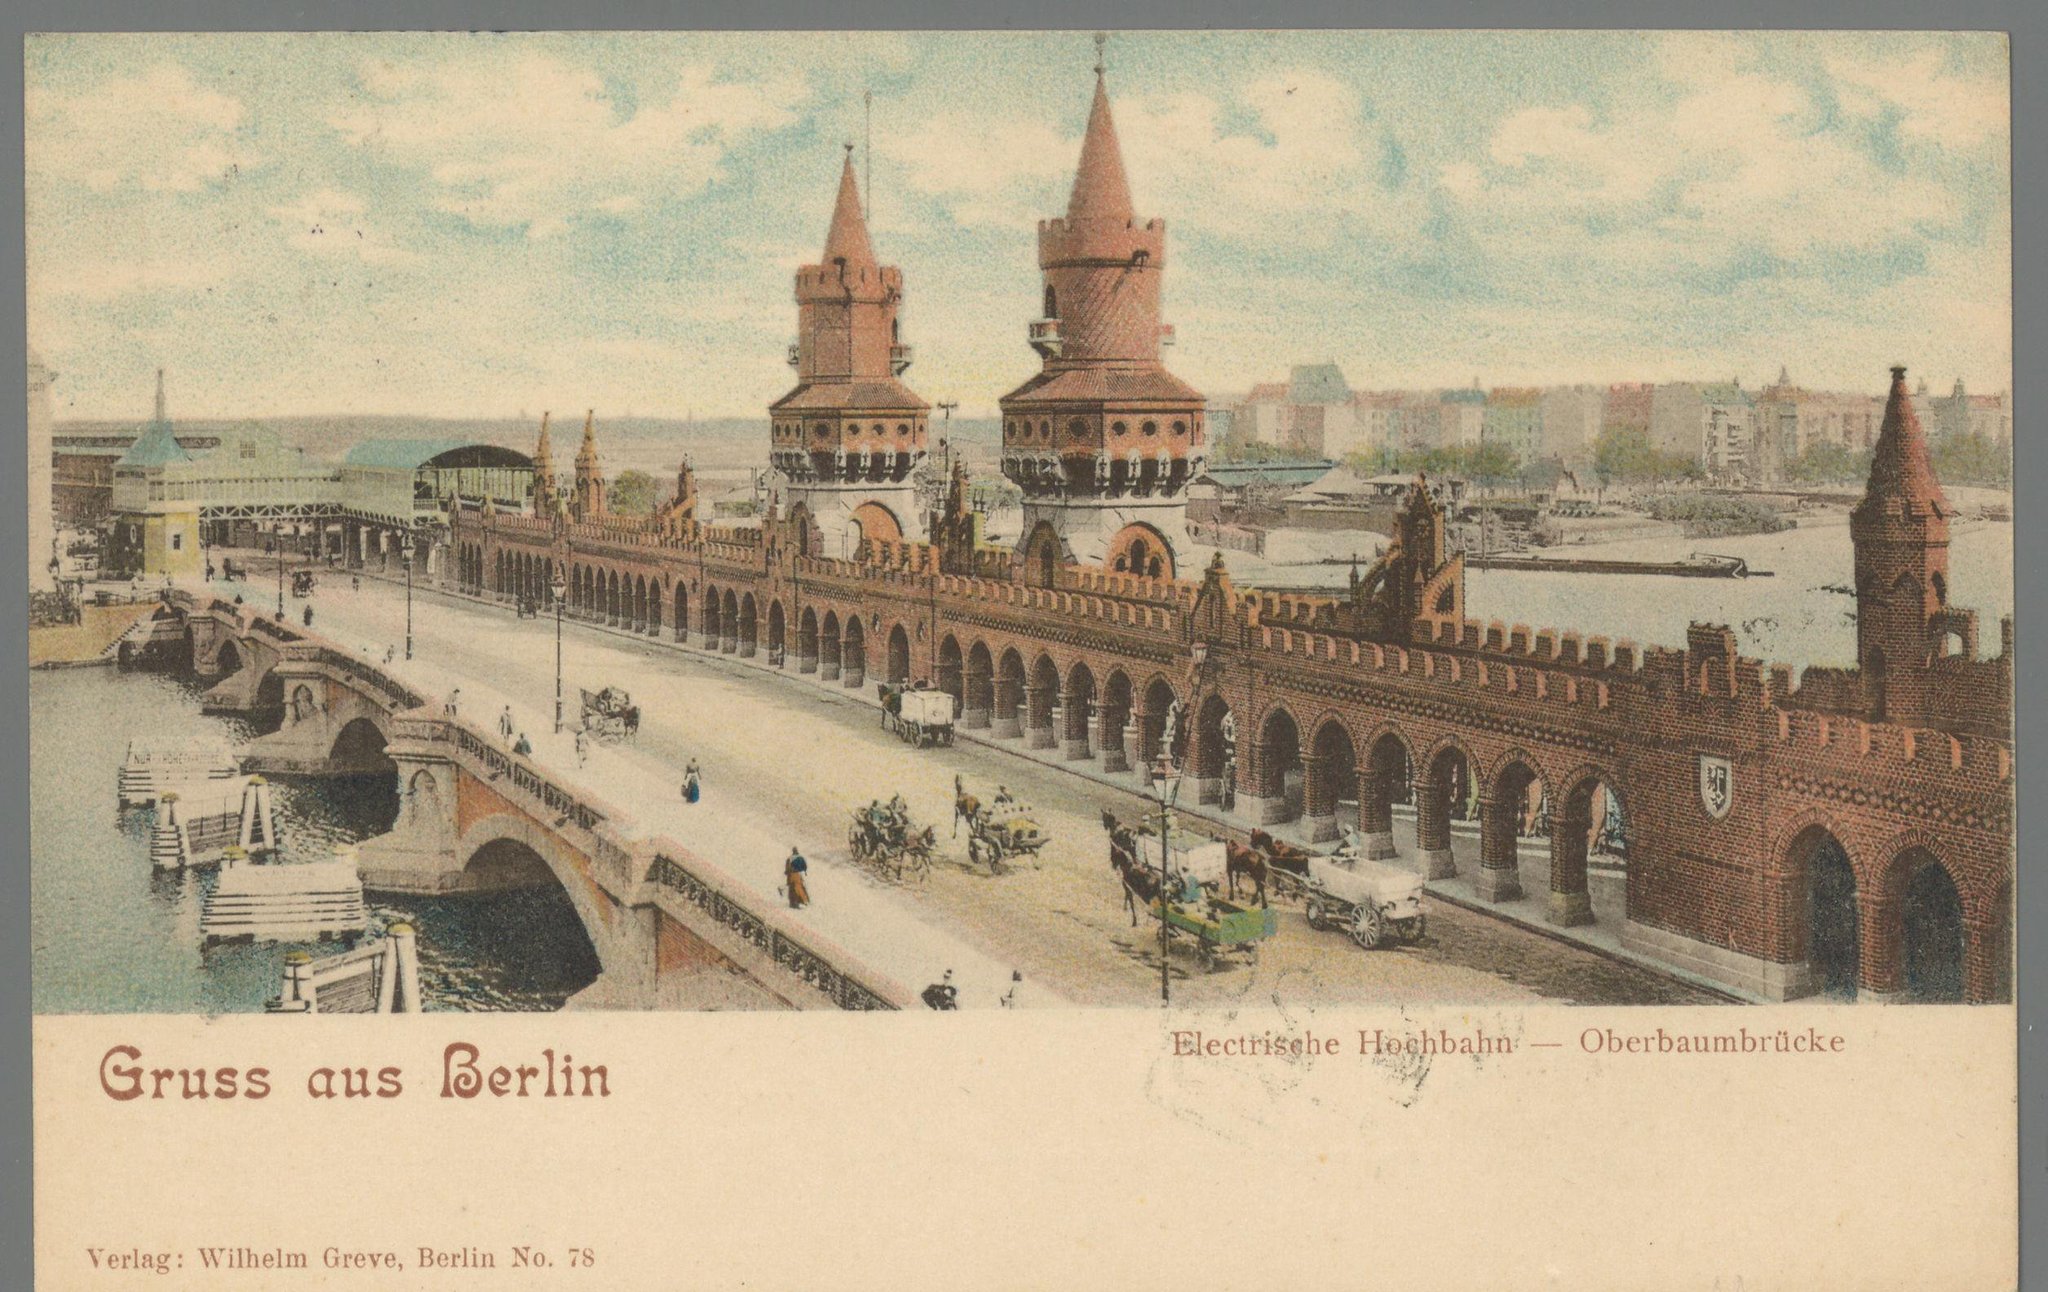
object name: photomechanical print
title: Gruss aus Berlin. Electrische Hochbahn - Oberbaumbrücke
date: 1890-1903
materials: cardboard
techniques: photograph, lithograph, writing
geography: berlin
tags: canals, waters (in city), bridge in city across river, canal, etc.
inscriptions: postage stamp